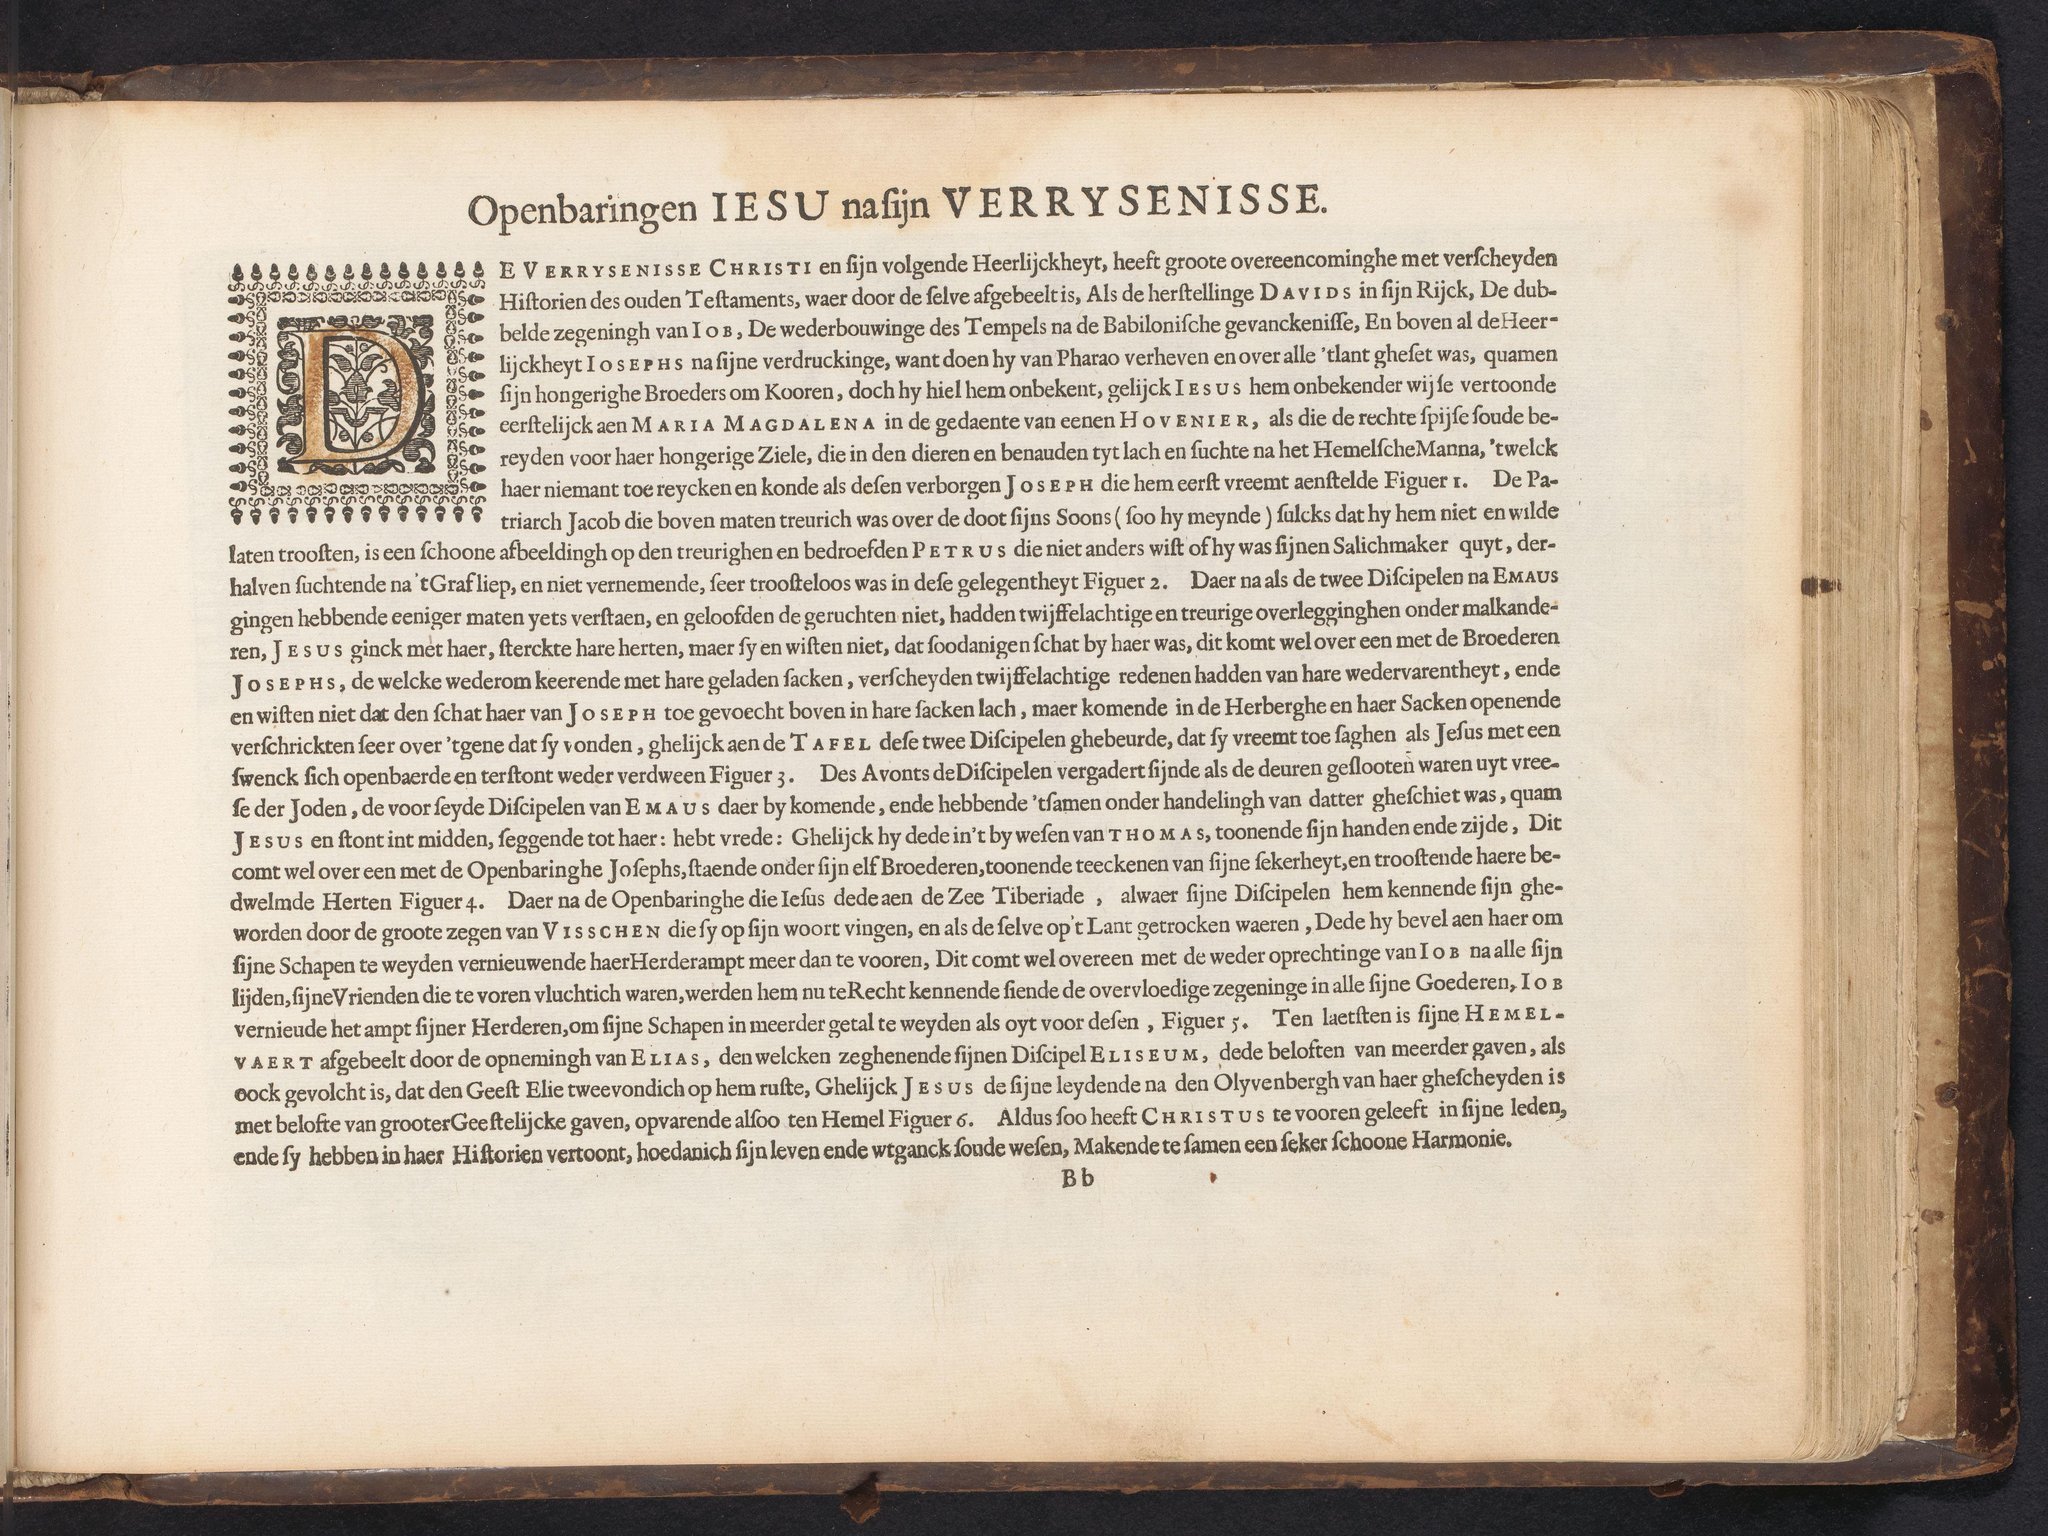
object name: album leaf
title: Den Grooten Figuer-Bibel (...)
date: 1646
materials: paper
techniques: hand coloring, letterpress printing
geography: alkmaar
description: Tekstblad bij een serie prenten over verschijningen van de opgestane Christus. Linksboven initiaal D. Dit blad maakt deel uit van een album.